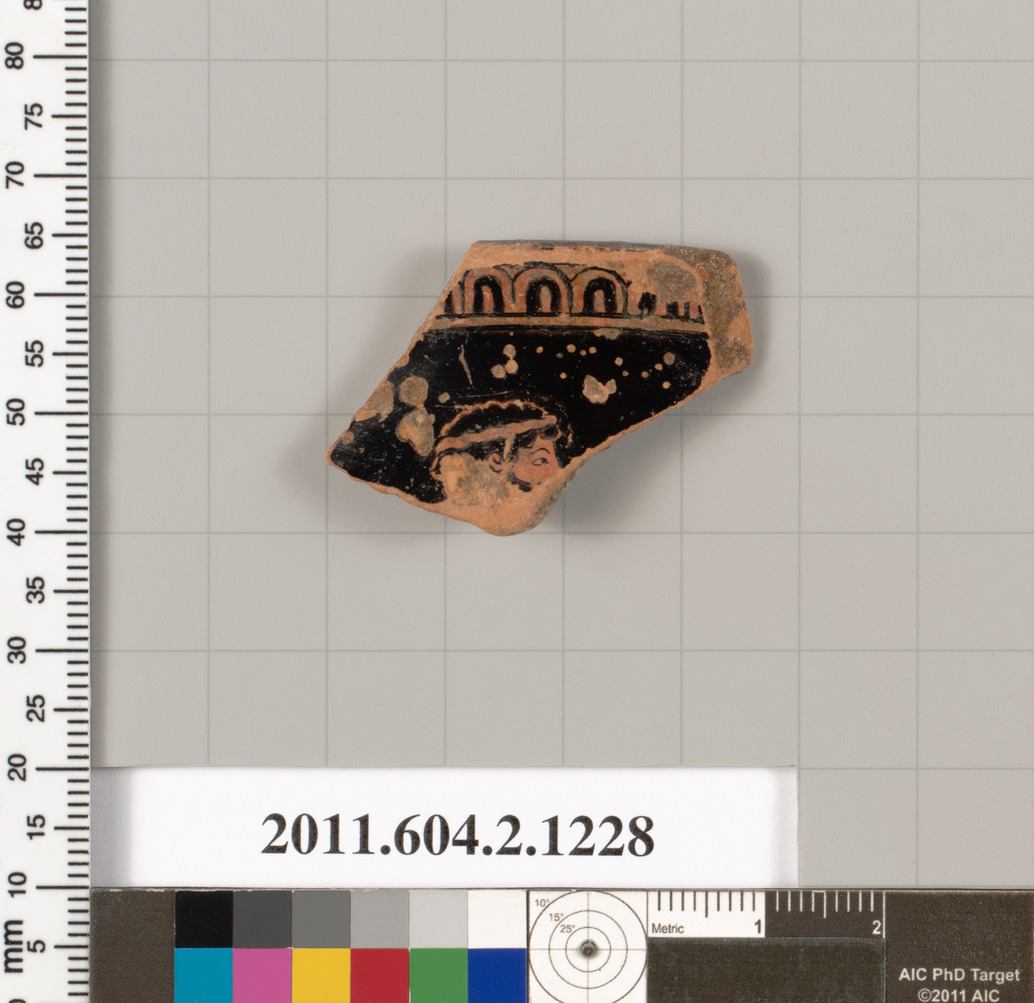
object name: rhyton fragment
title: Terracotta rhyton (vase for libations or drinking)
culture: greek, attic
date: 475-451 BCE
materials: terracotta